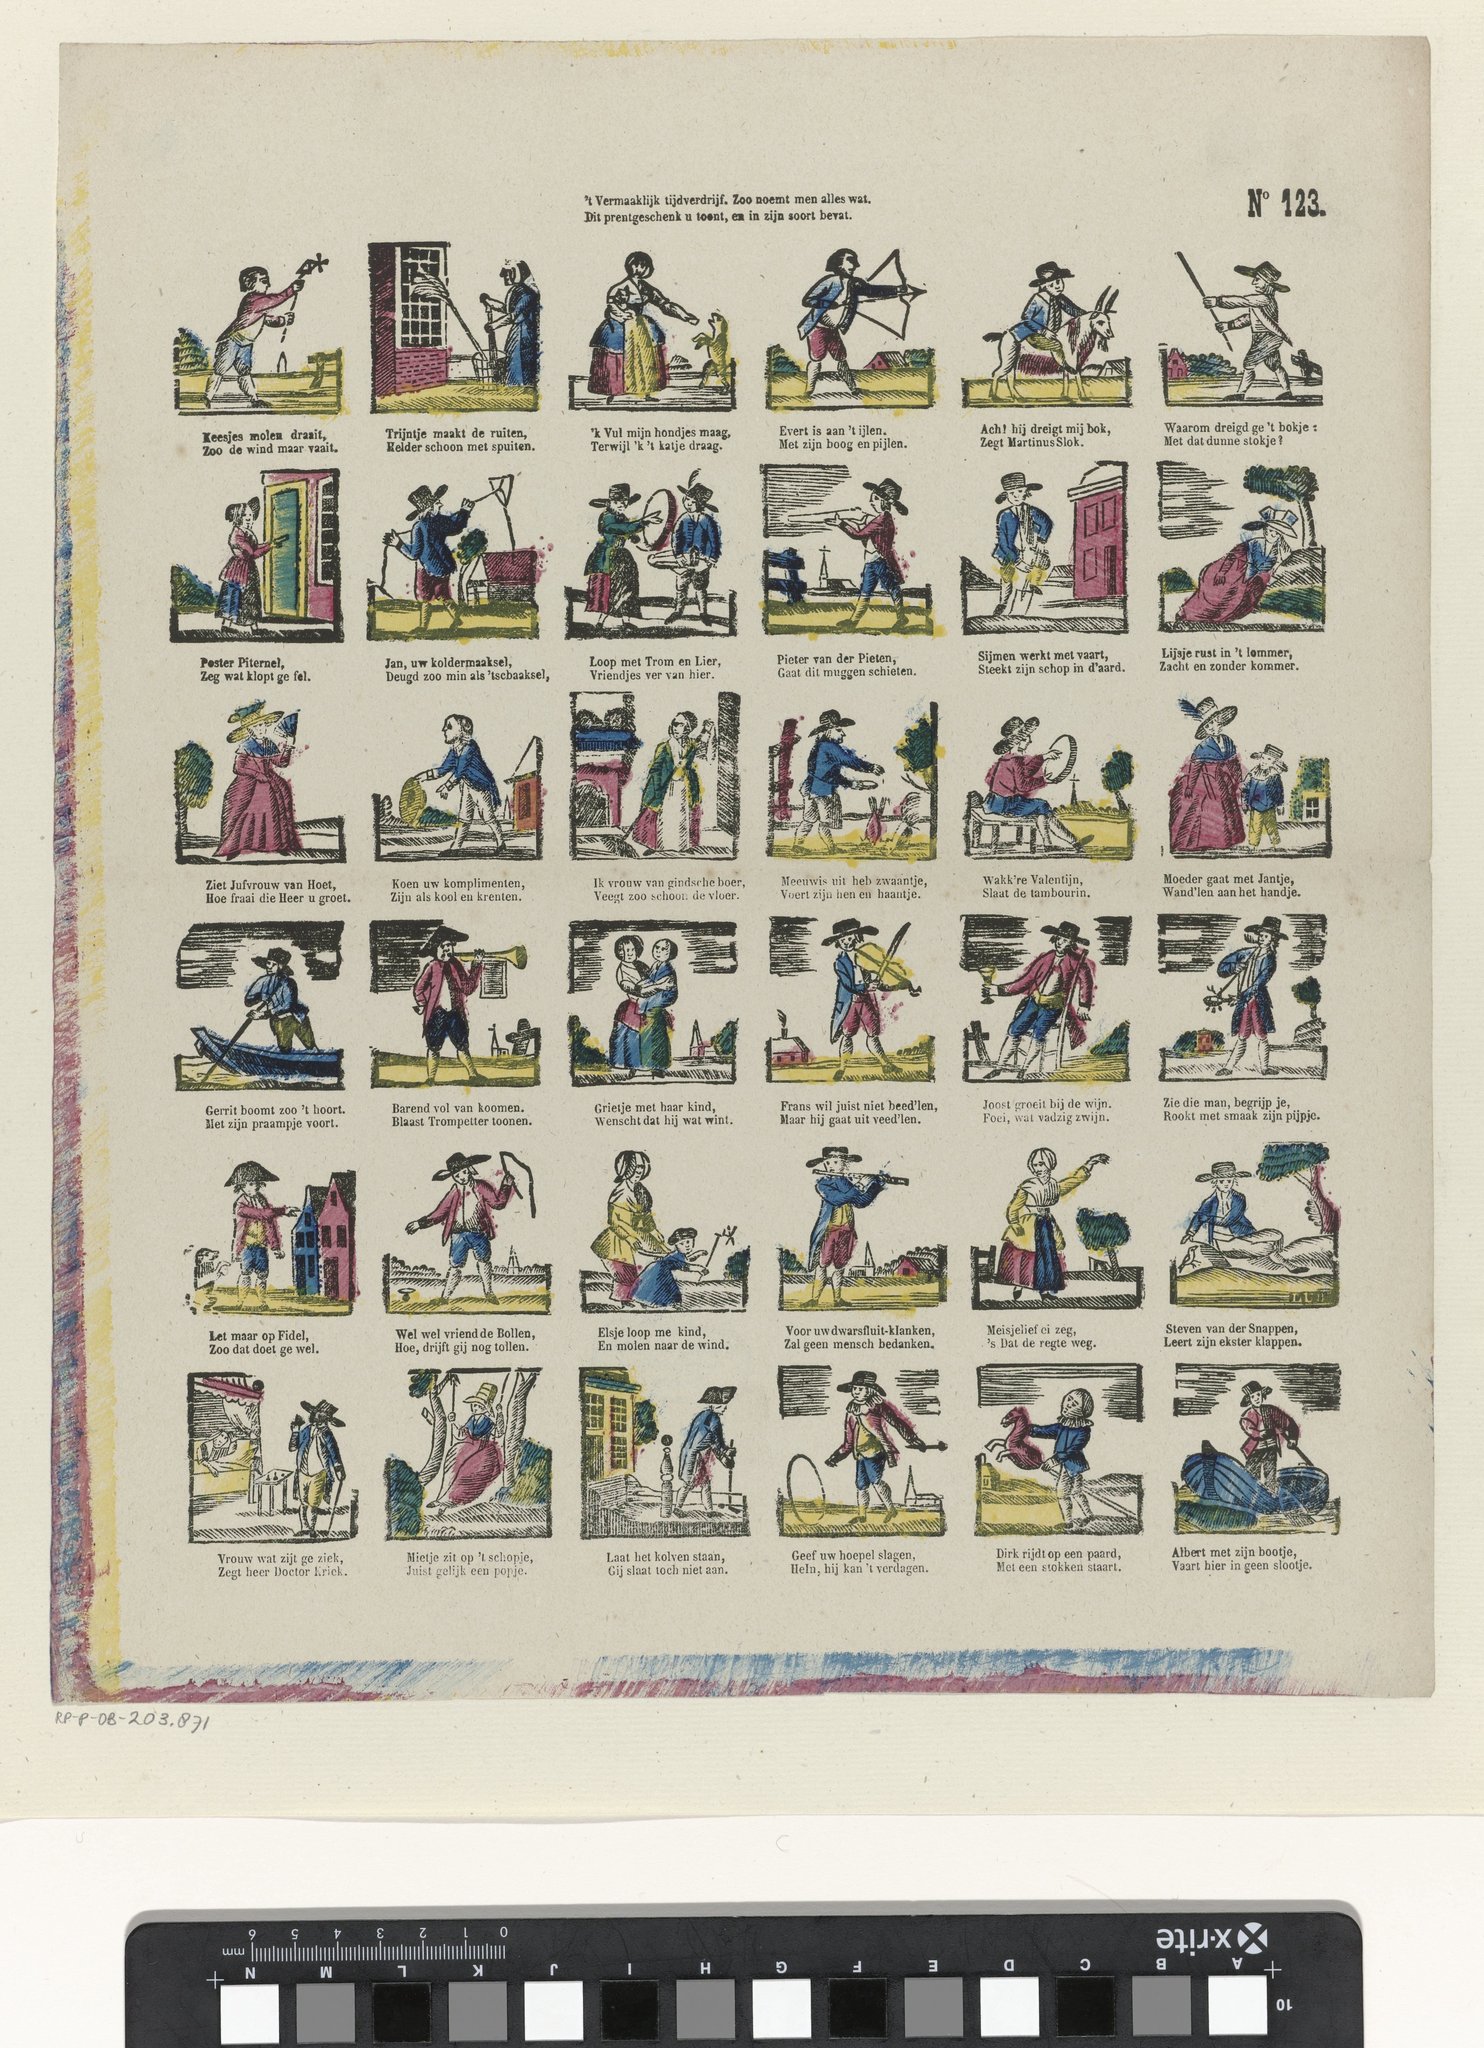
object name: print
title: 't Vermaaklijk tijdverdrijf. Zo noemt met alles wat. / Dit prentgeschenk u toont, en in zijn soort bevat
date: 1827-1894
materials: paper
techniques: colour, letterpress printing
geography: schaarbeek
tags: musician, children's games and plays, characters (human types), games using special objects (marbles, top, hoop, etc.)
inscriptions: collector's mark: Lugt 2760, collector's mark: ‘Edw. Ipers / Oever 27, / Antwerpen.’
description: Blad met 36 voorstellingen van spelen en bezigheden voor kinderen en volwassenen. Onder elke afbeelding een tweeregelig vers. Genummerd rechtsboven: No 123.